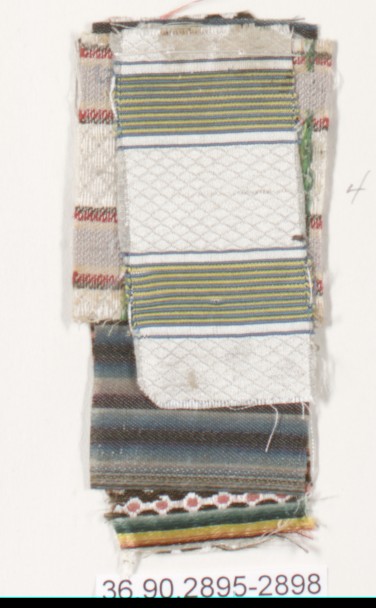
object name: piece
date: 1801-1900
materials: silk